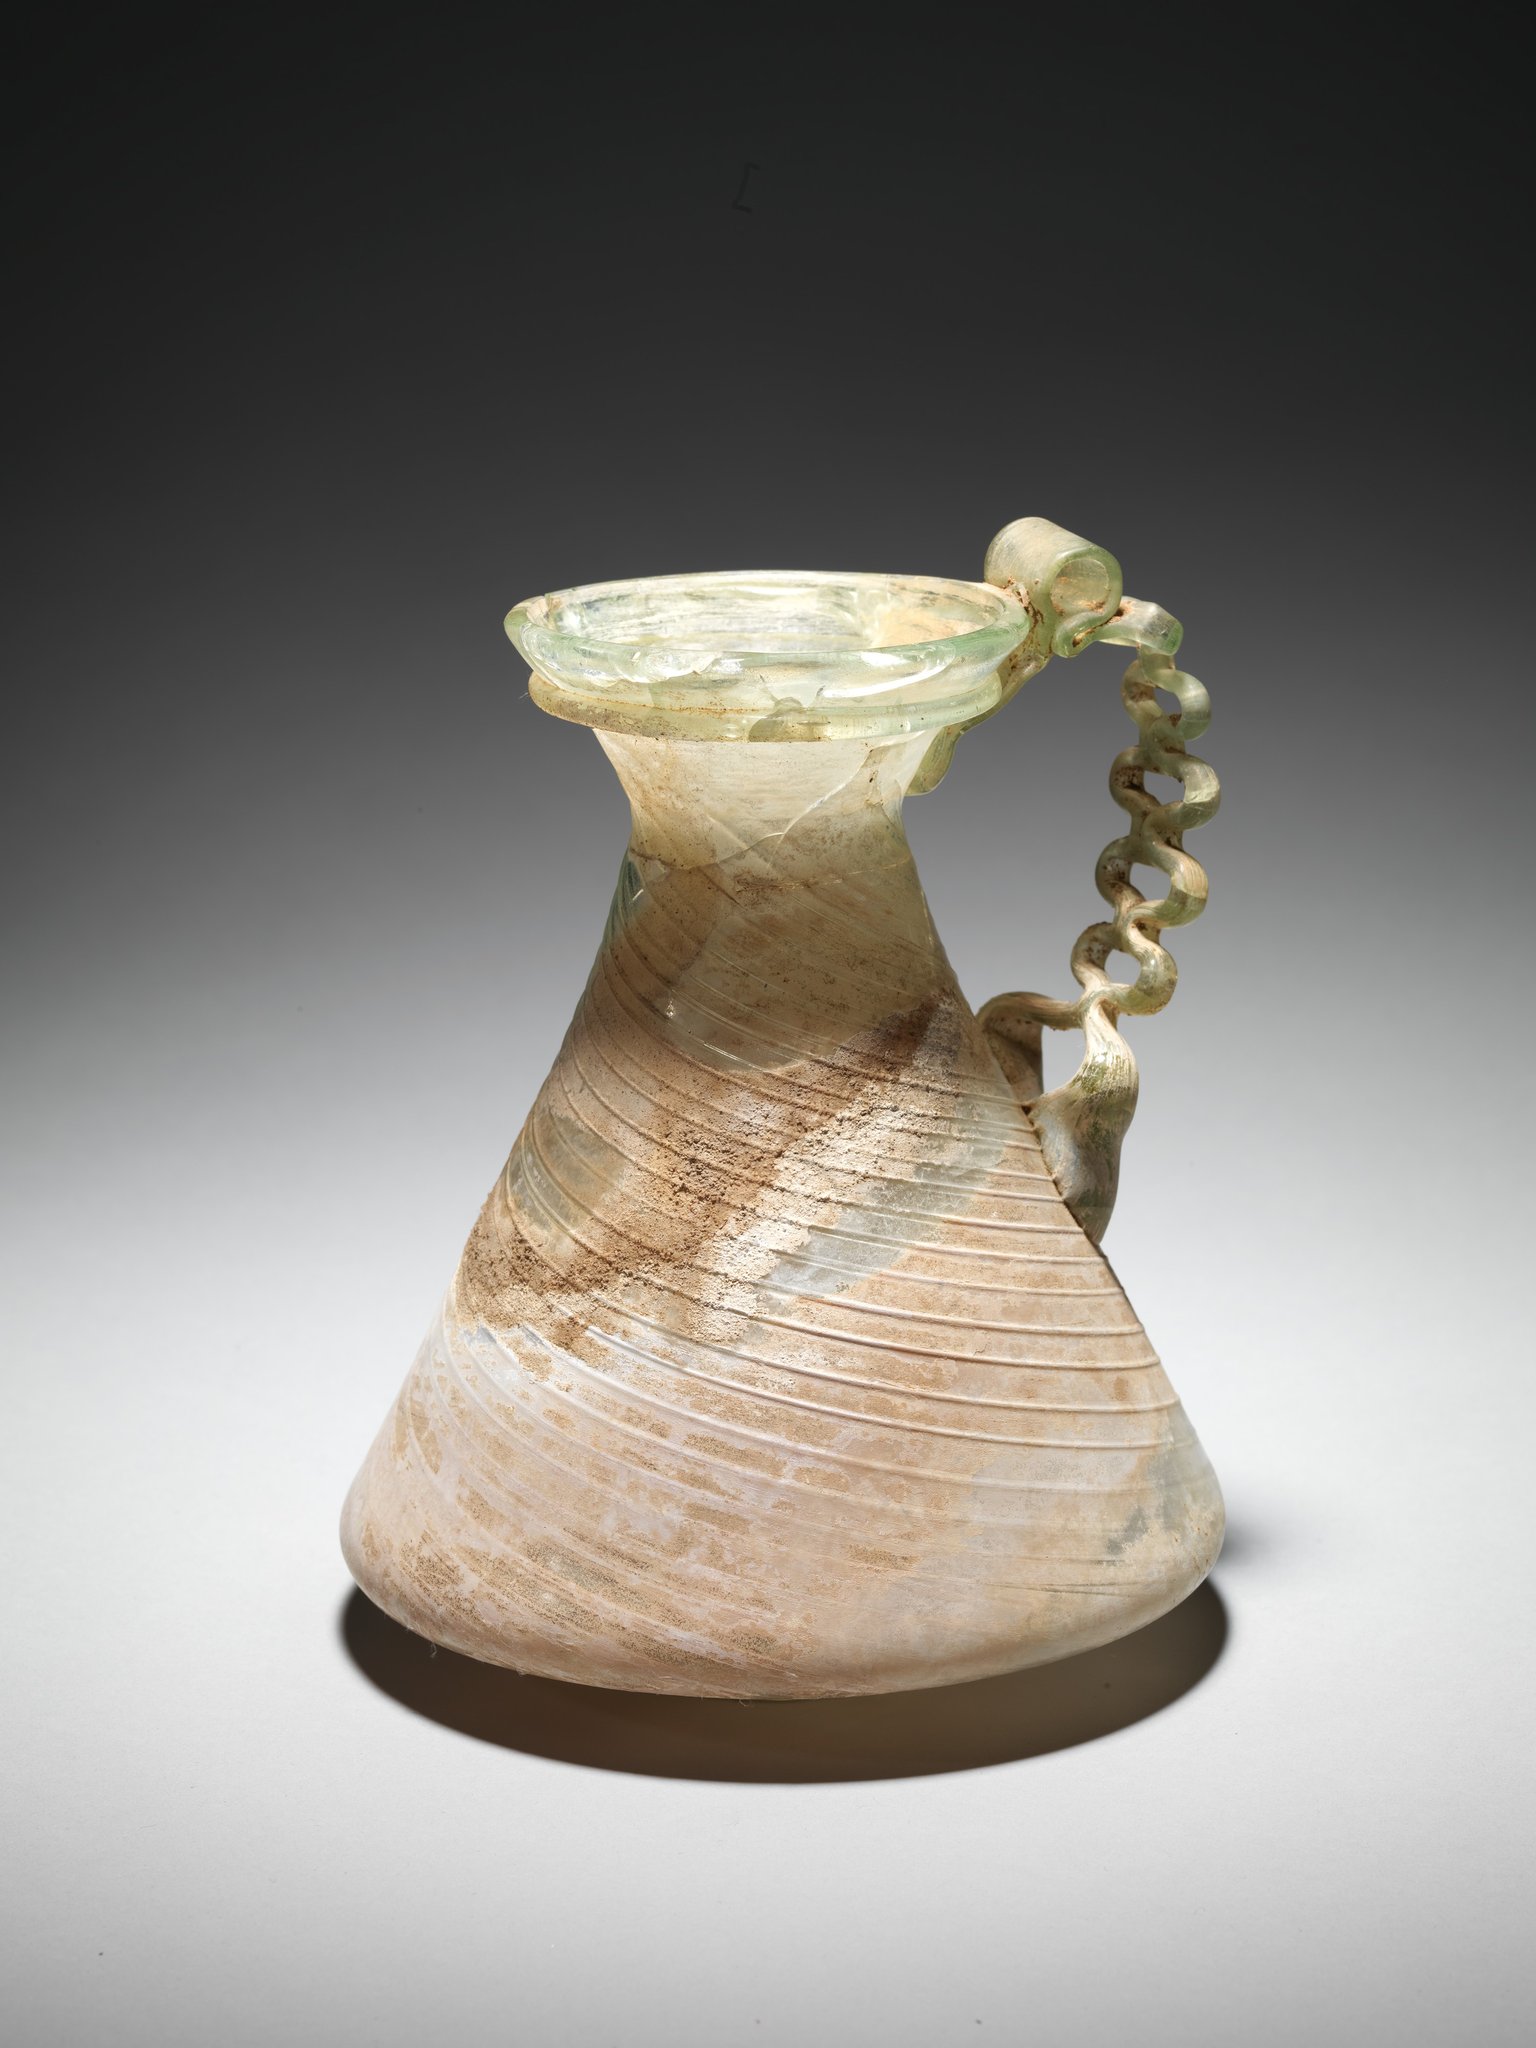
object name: jug with chain handle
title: Glass jug with chain handle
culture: roman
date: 201-300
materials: glass